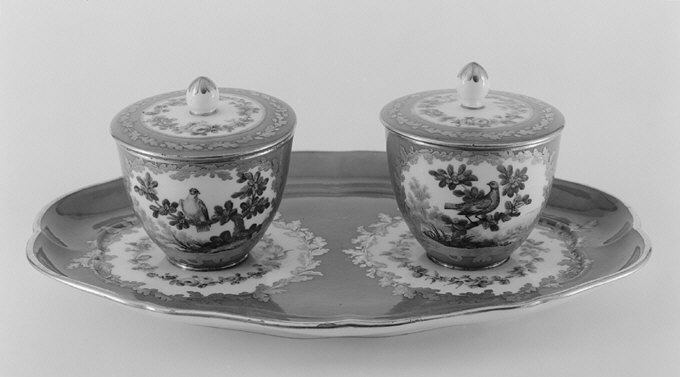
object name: stand with jam pot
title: Stand with jam pots (plateau à deux pots de confiture) (one of a pair) (part of a service)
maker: sèvres manufactory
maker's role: manufactory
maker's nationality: french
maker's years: 1740-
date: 1771-1772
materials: soft paste porcelain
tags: birds,trees